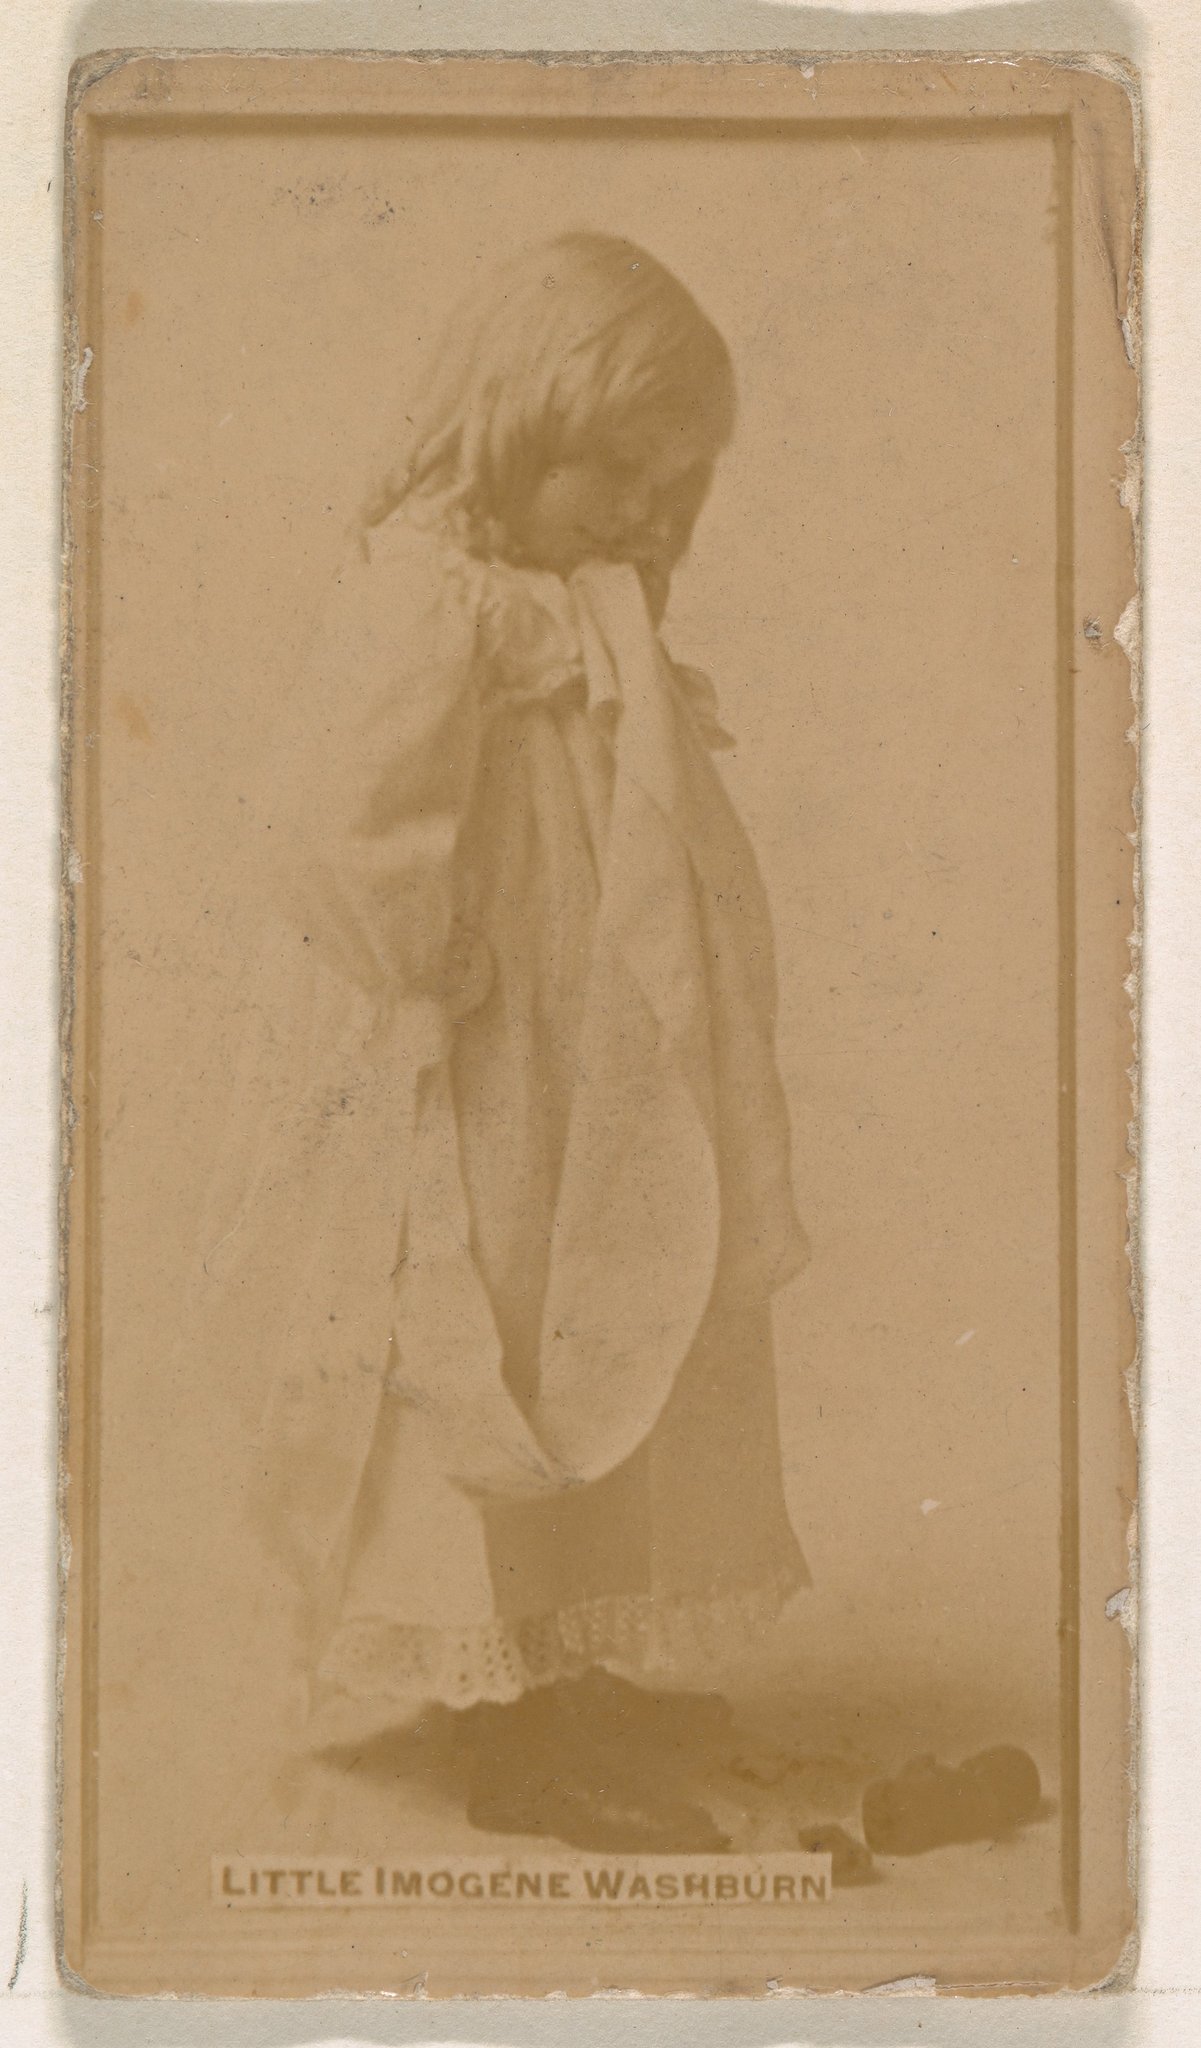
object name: photograph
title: Little Imogene Washburn, from the Actresses series (N245) issued by Kinney Brothers to promote Sweet Caporal Cigarettes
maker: kinney brothers tobacco company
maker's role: publisher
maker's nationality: american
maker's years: 1869-2011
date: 1890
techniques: albumen silver print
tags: girls,portraits,actresses